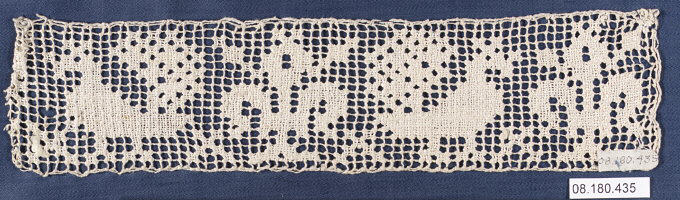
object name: border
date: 1501-1600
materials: linen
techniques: embroidery